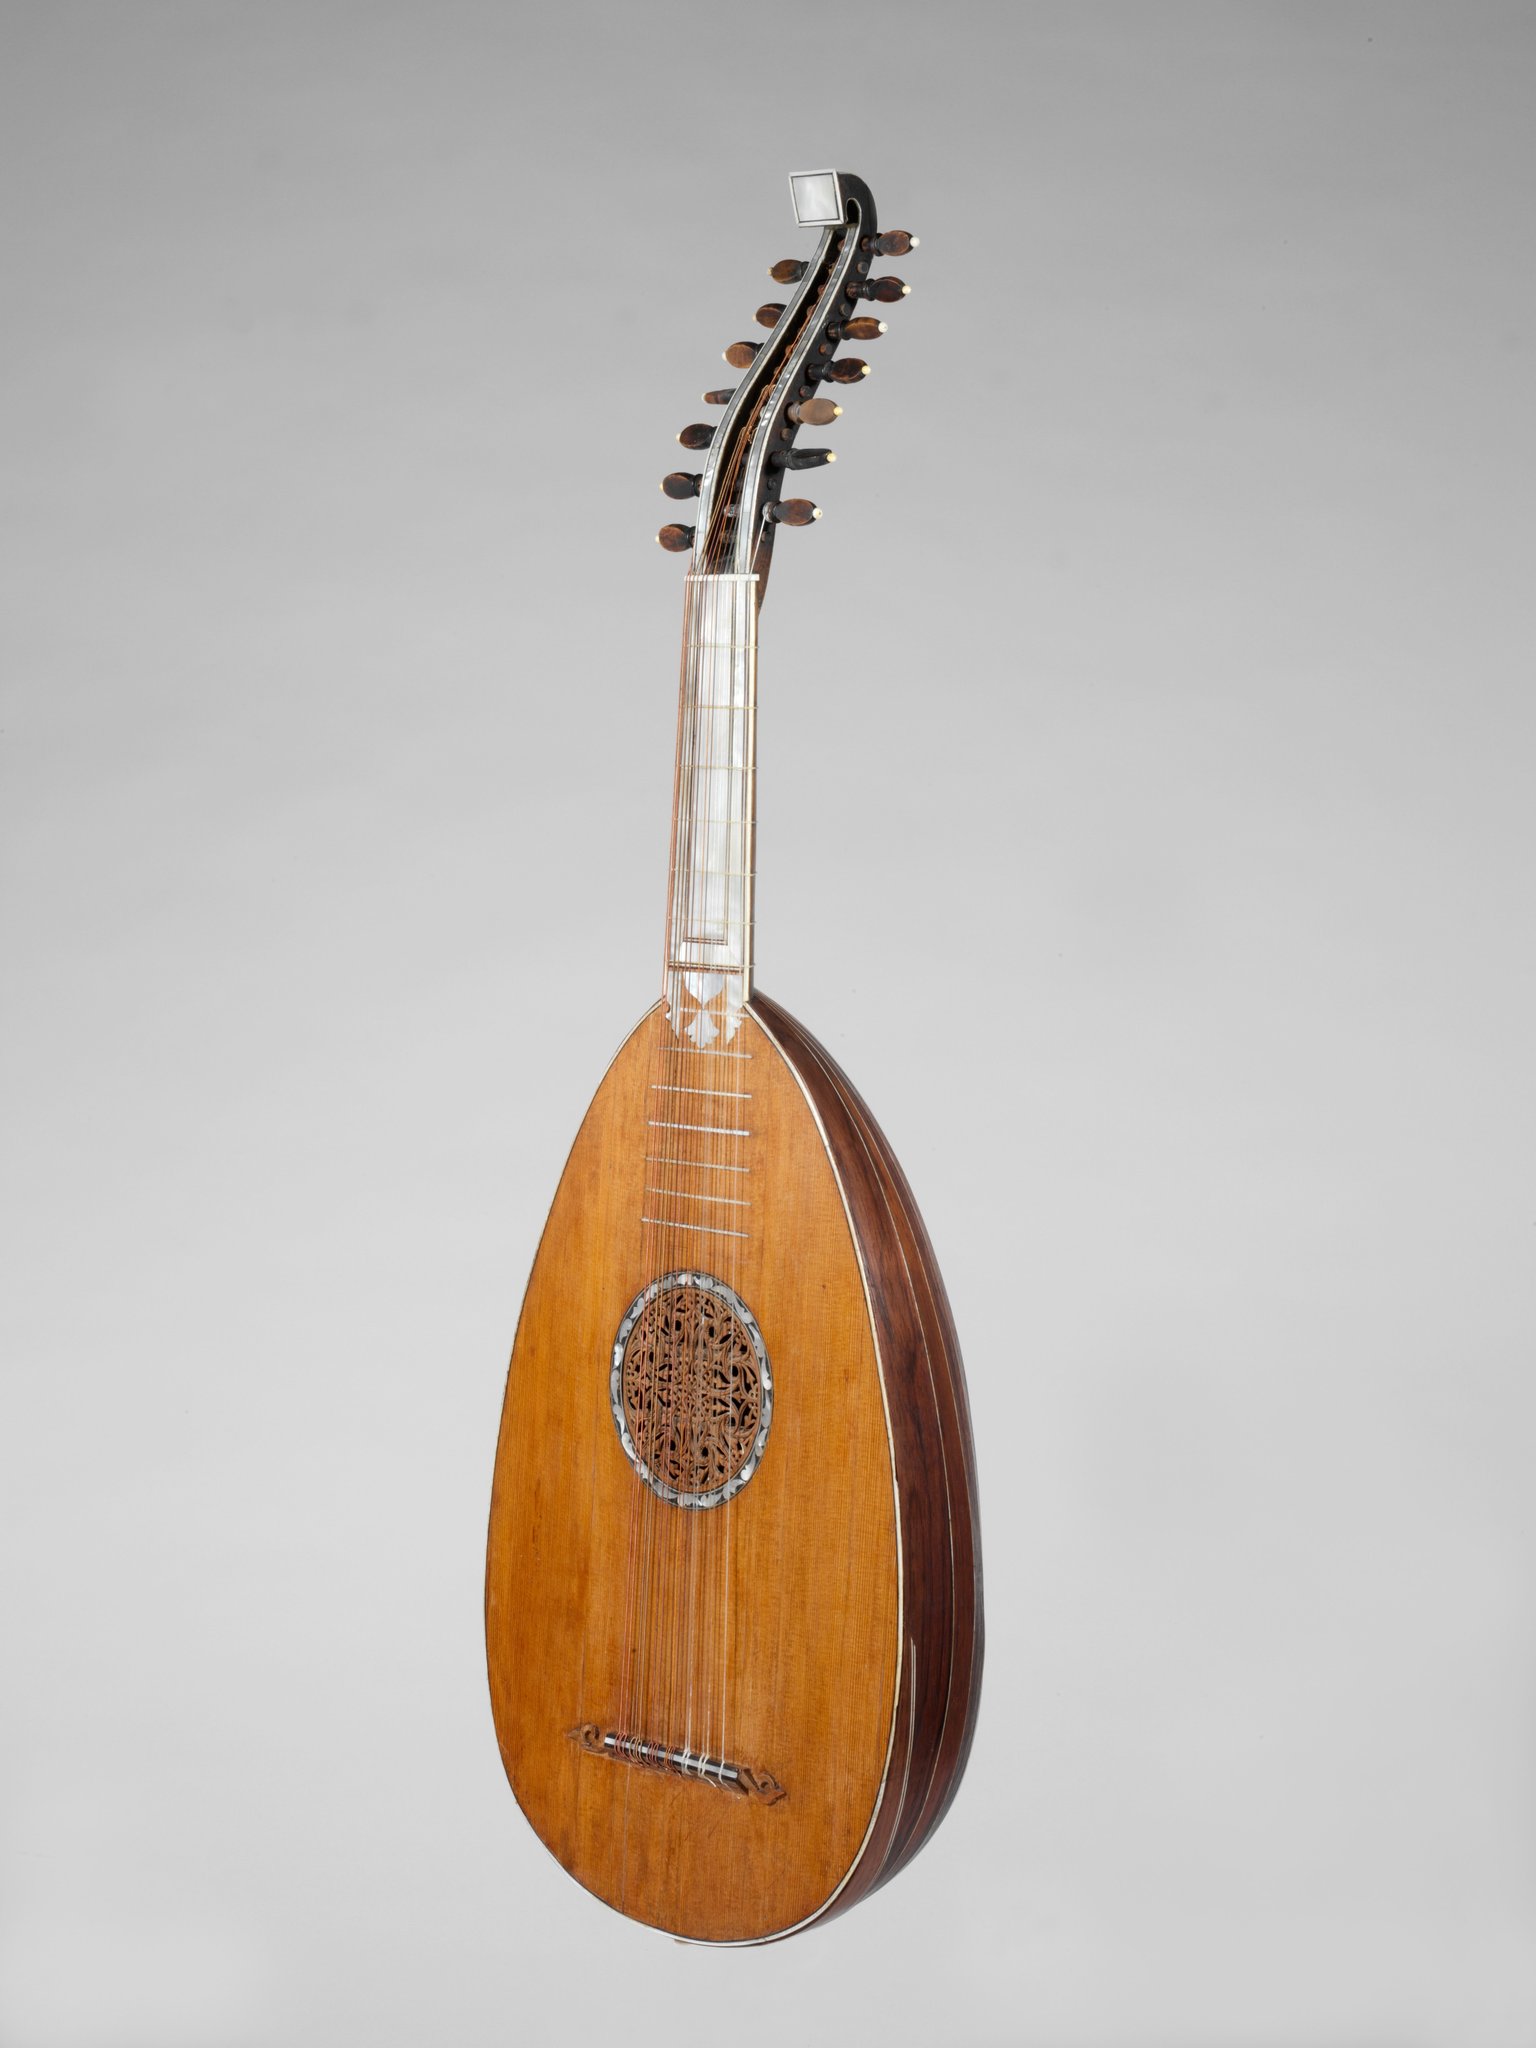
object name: mandola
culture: italian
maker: giuseppe presbler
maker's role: maker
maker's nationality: german, active italy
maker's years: 1760-1801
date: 1797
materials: bone, mother of pearl, wood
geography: italy